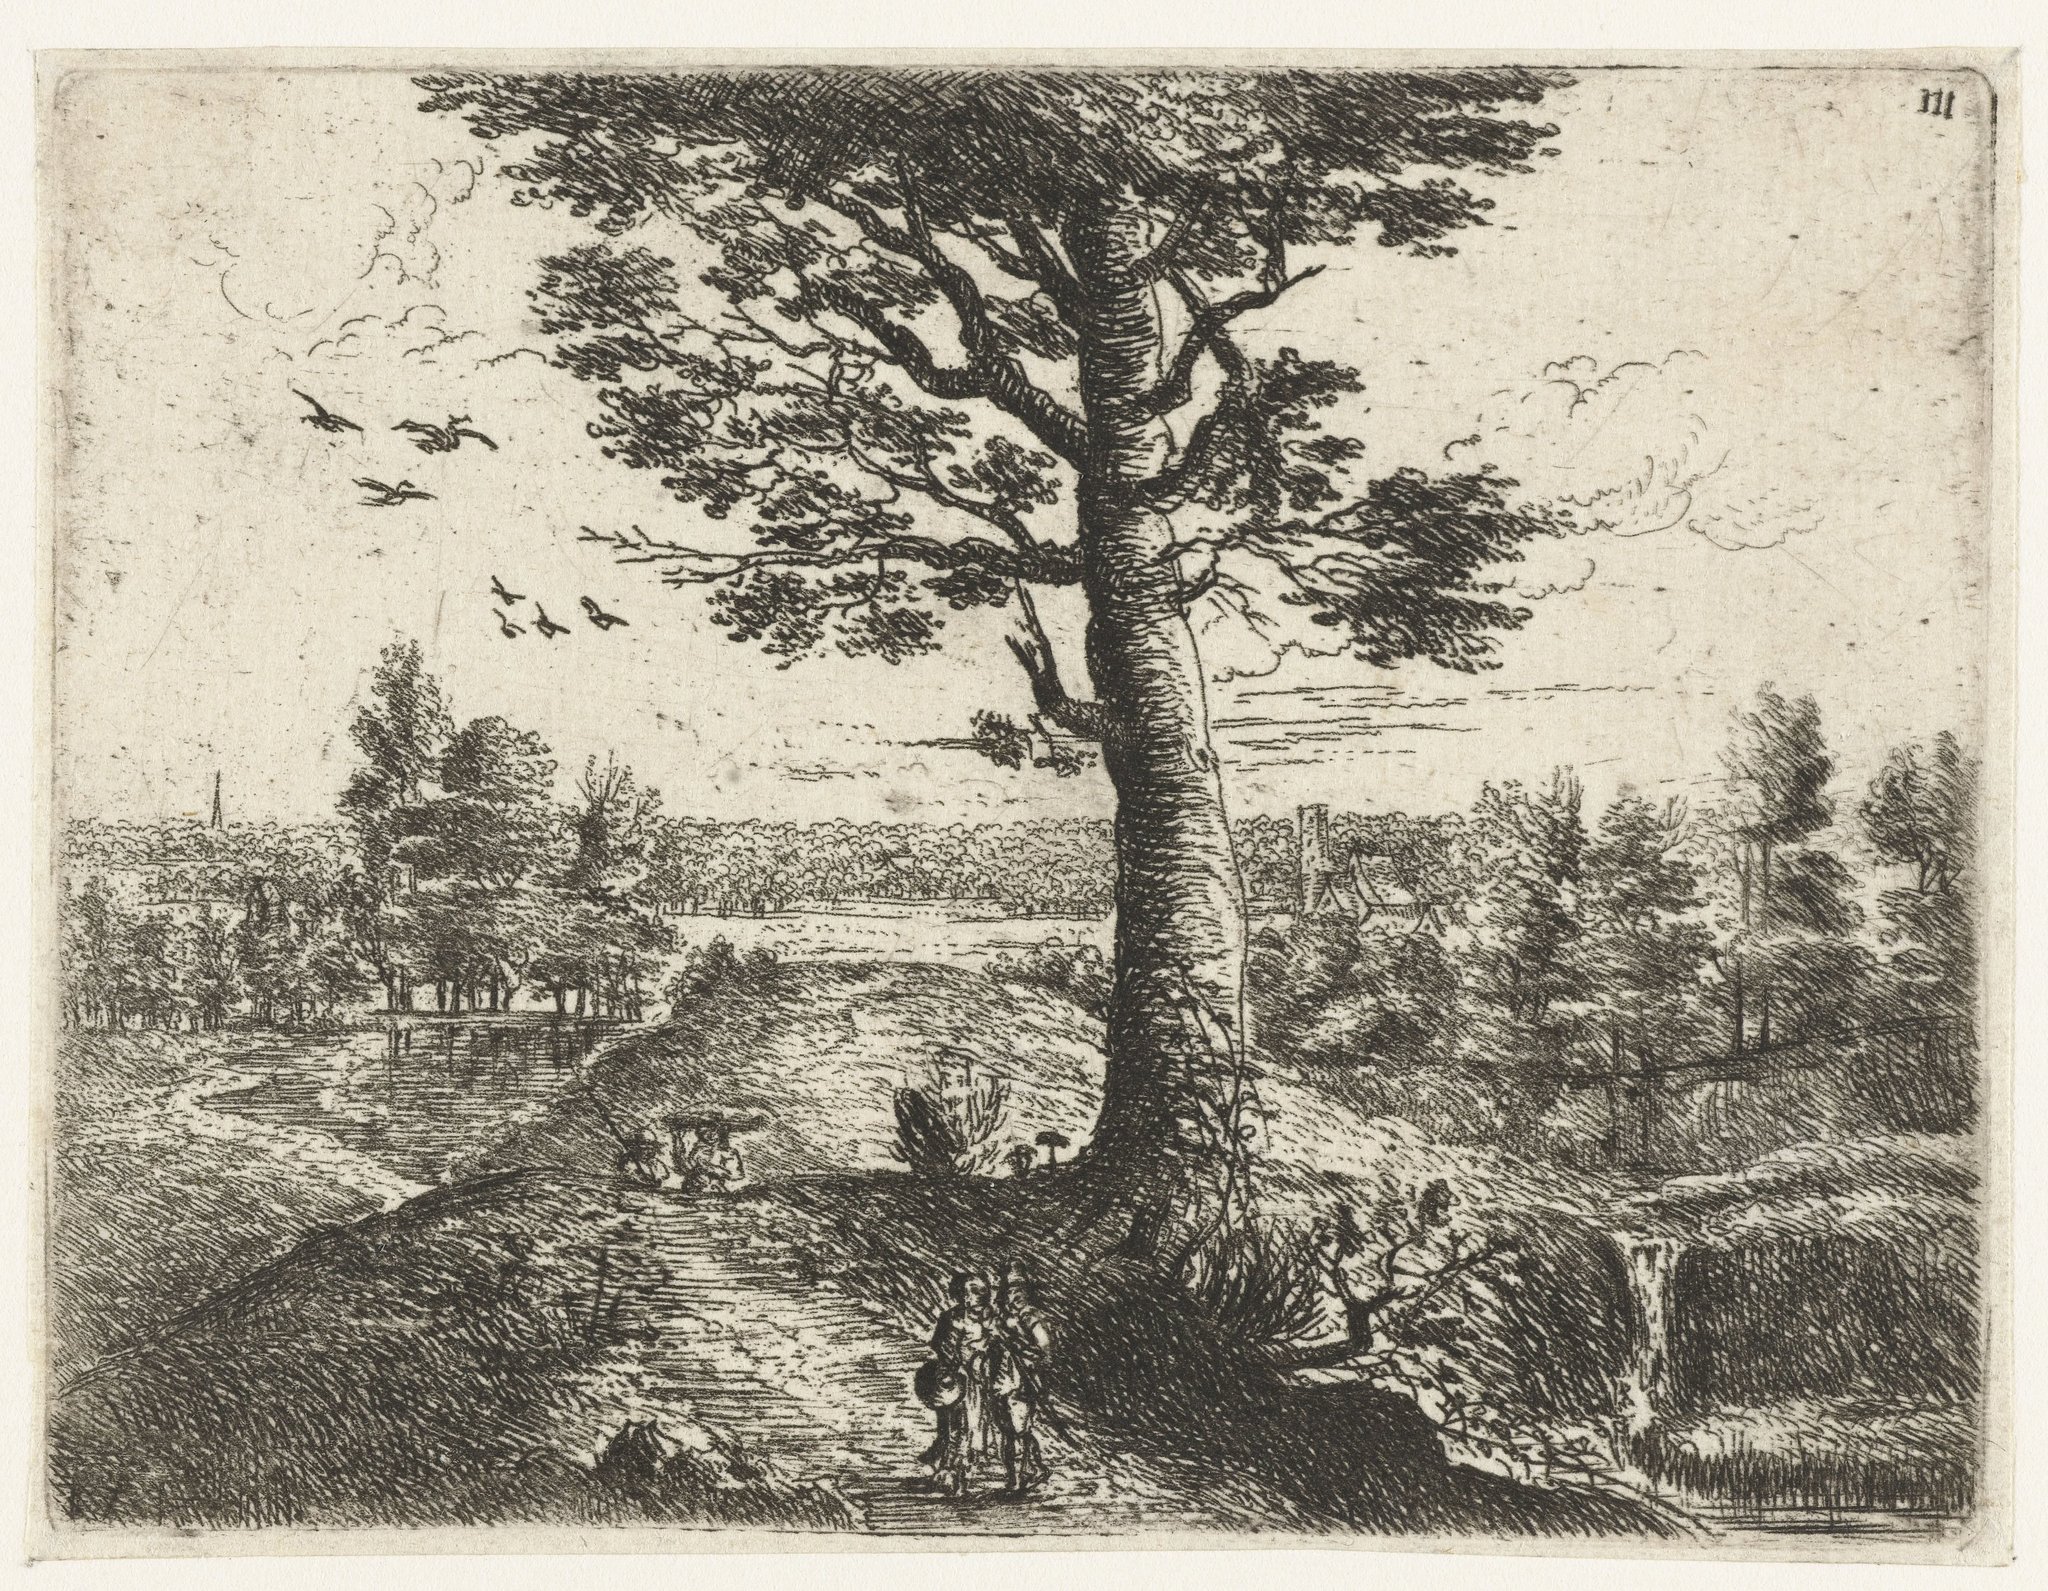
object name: print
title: Acht landschappen naar Lucas van Uden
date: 1637-1679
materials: paper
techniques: engraving, etching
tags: trees, couple of lovers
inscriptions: collector's mark: Lugt 2228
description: Derde uit een serie van acht. Landschap met een grote boom op een heuvel en een wandelend paar.